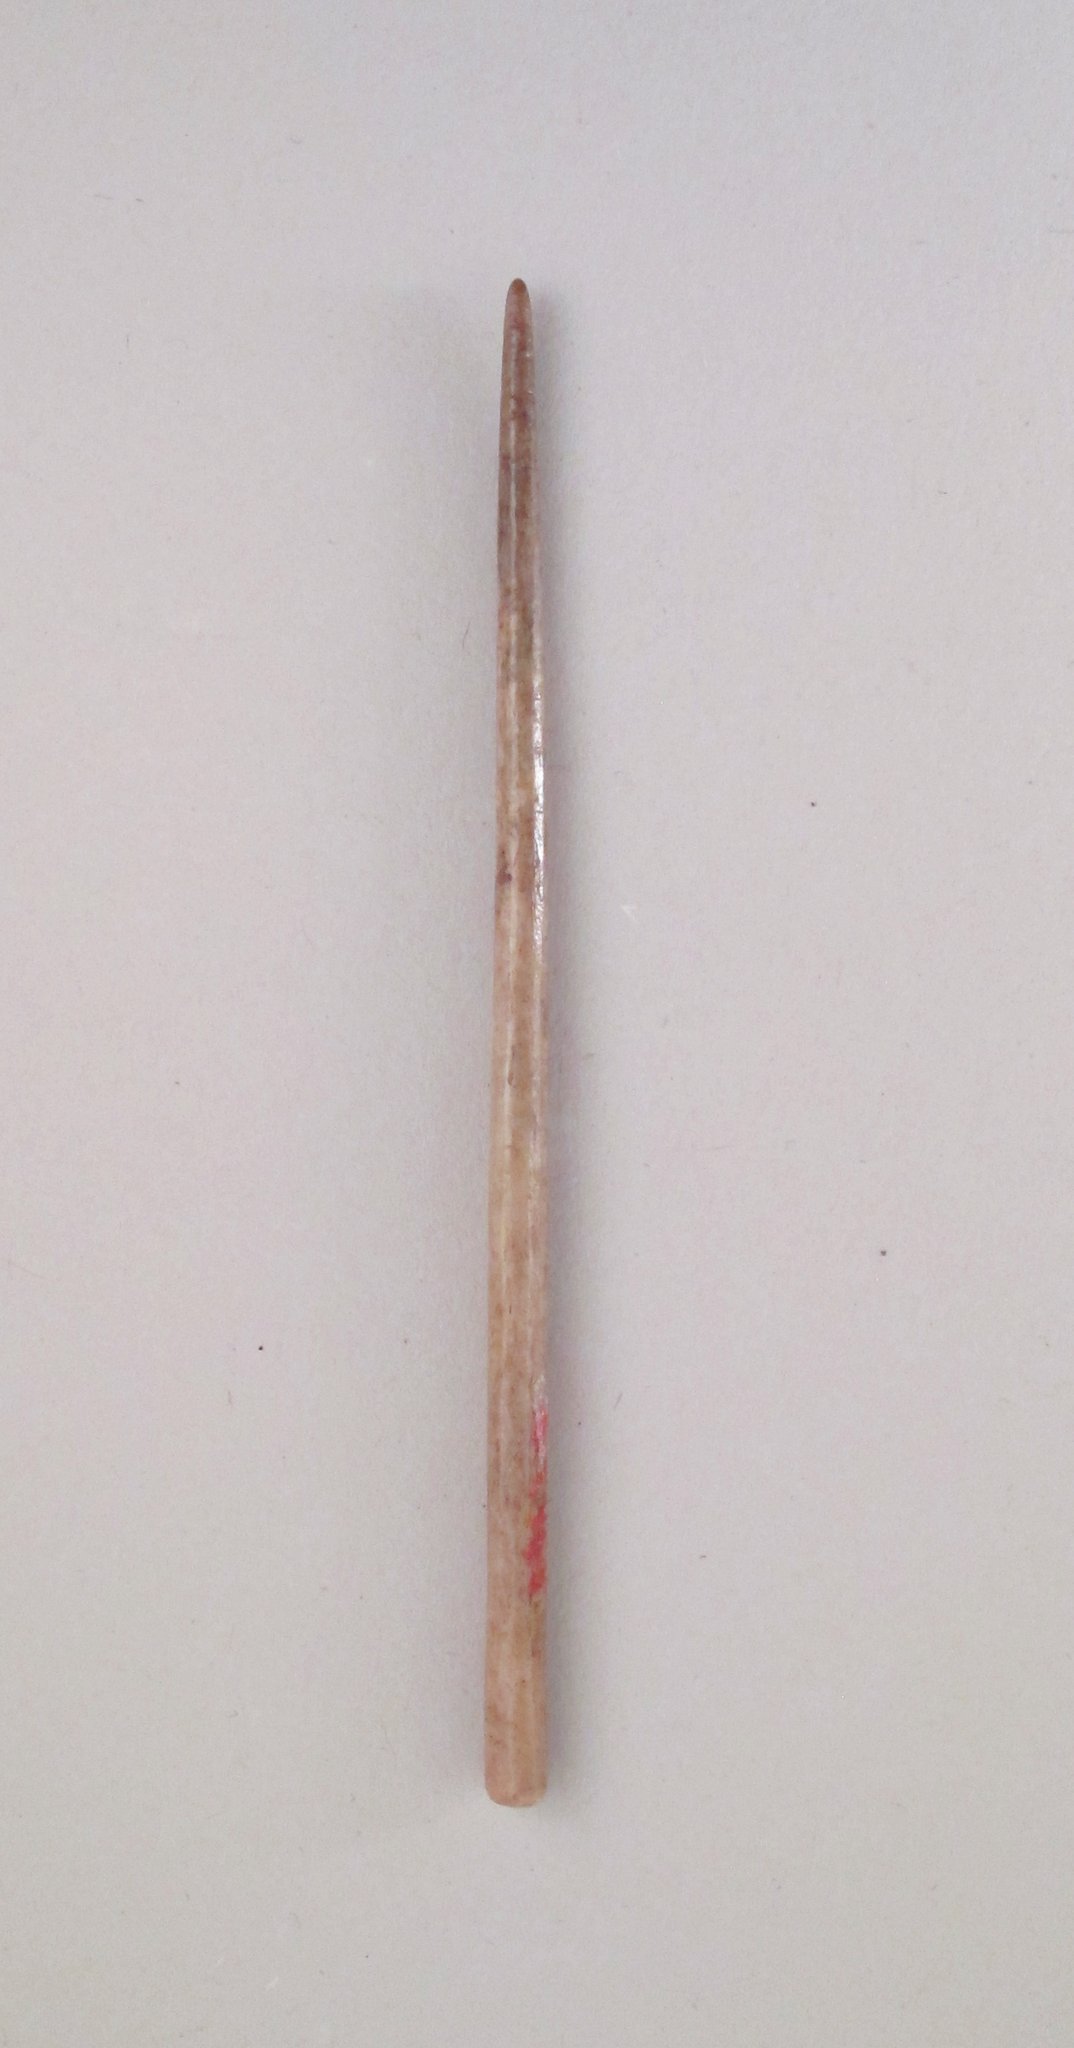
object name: stylus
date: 7000 BCE-330 CE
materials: bone, ivory